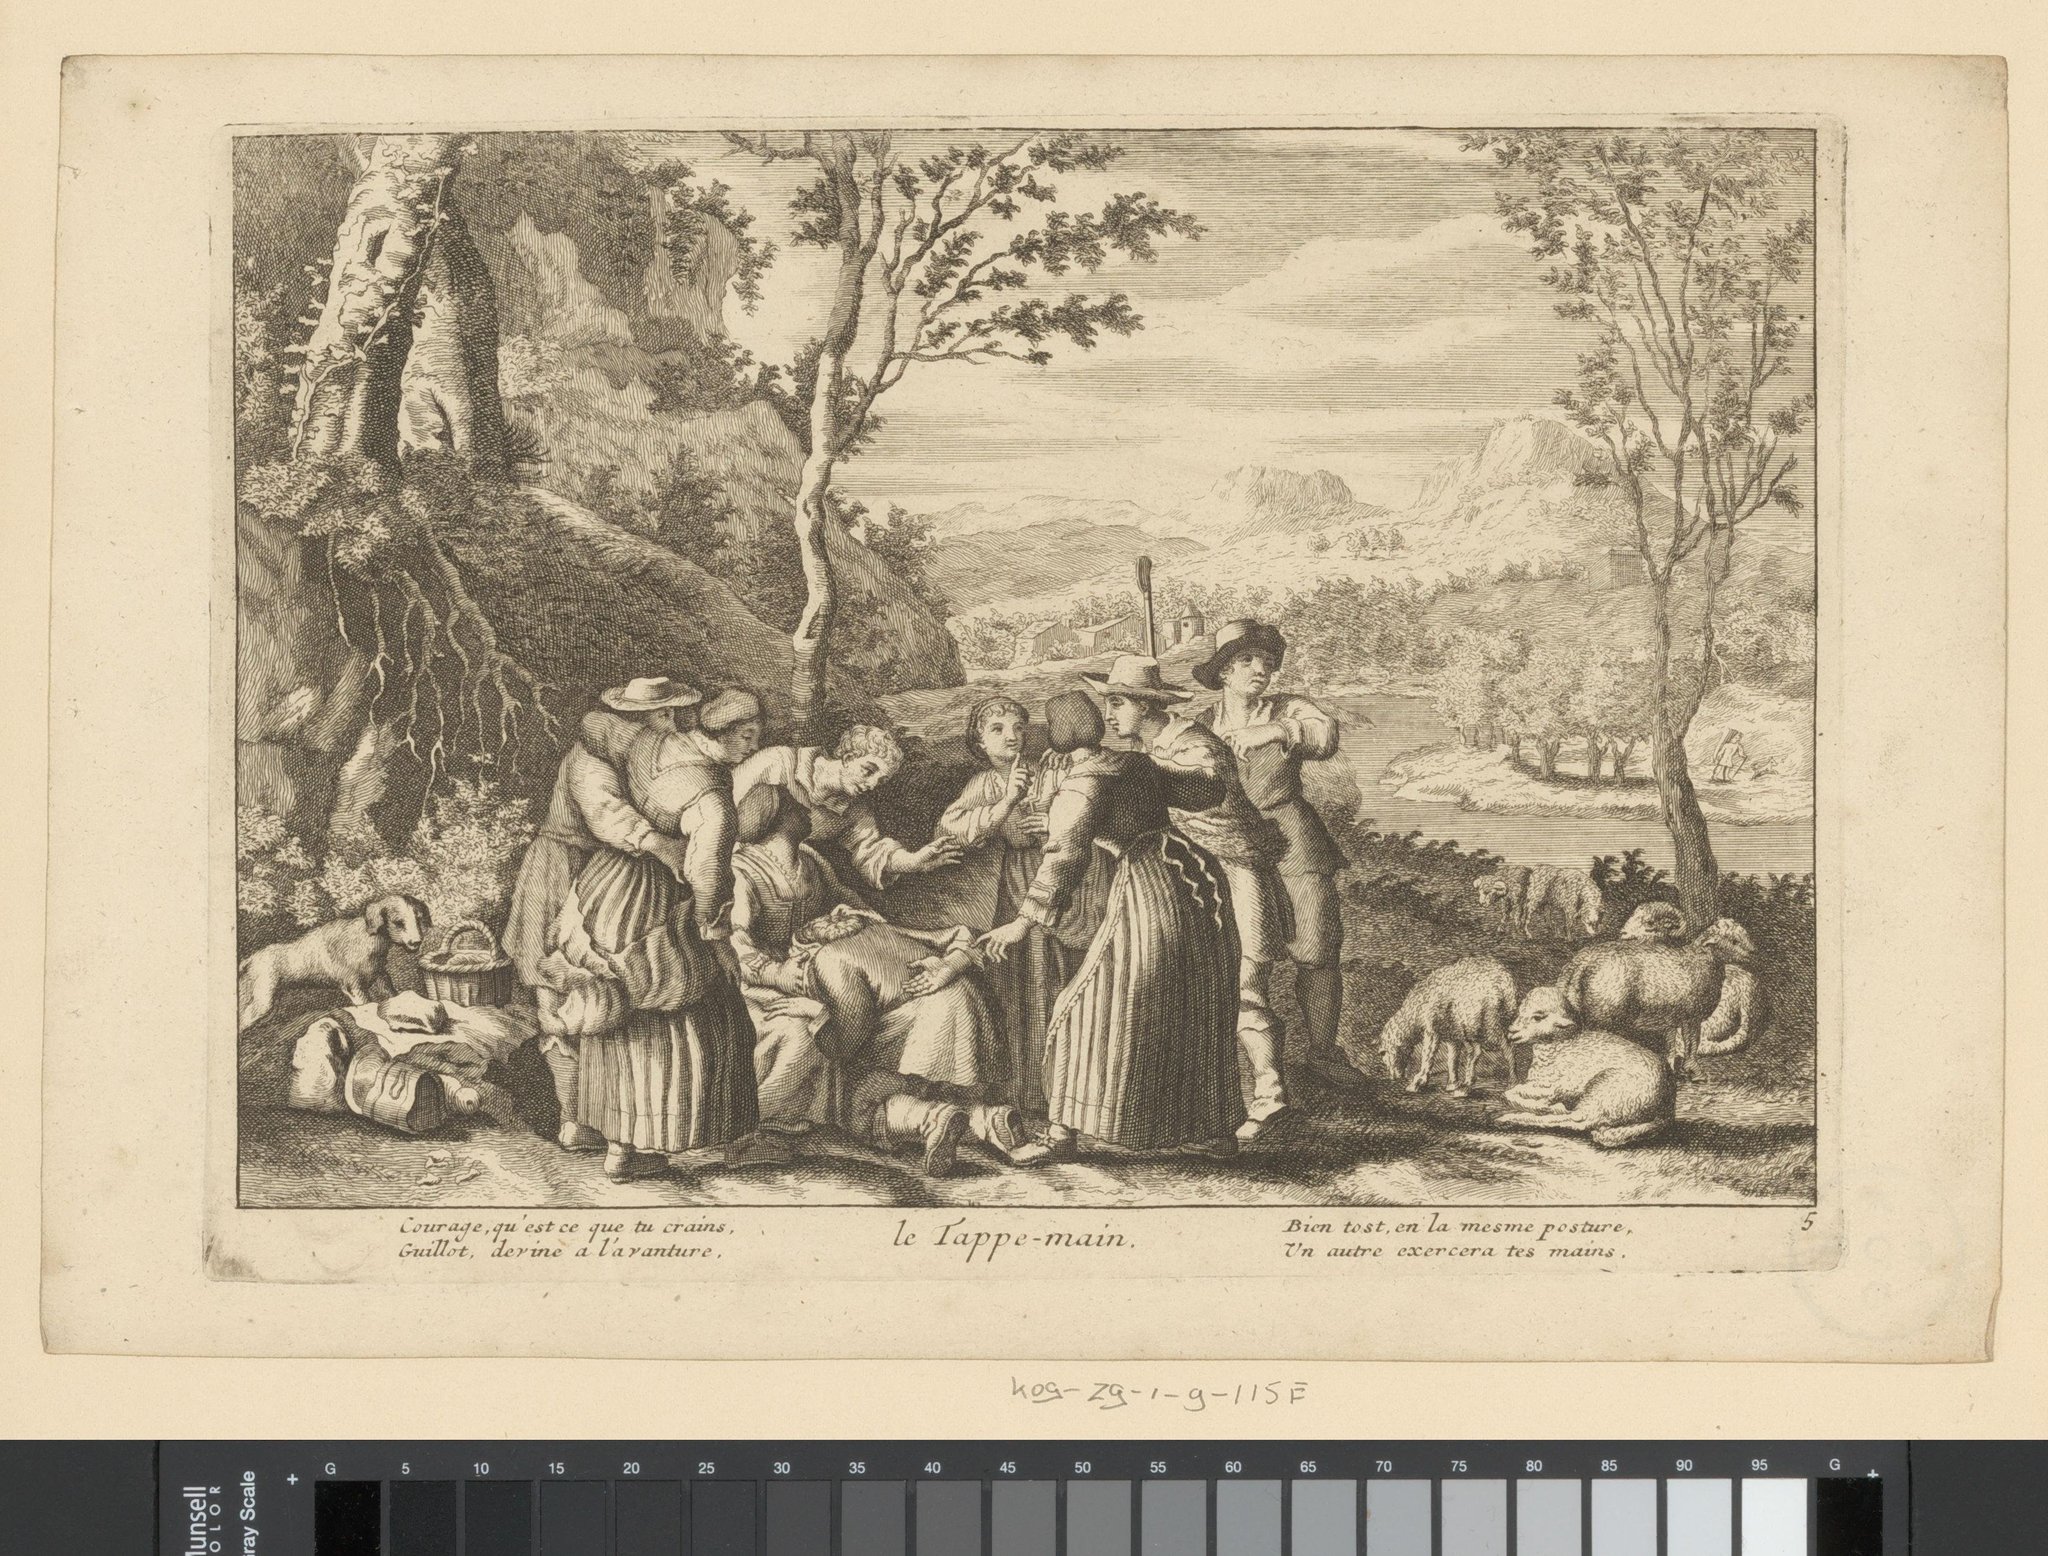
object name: print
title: Figuren een spelen een spel blindeman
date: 1670-1726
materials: paper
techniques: engraving, etching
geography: amsterdam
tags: swinging (children's game), ninepins, skittles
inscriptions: collector's mark: Lugt 1641, stamp:, stamp:, collector's mark: Lugt 1641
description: Onderaan genummerd: 5. Onderwerpsrubrieken binnen de Atlas Zeden en Gewoonten: Handel, nijverheid en verkeer, Boerenleven.